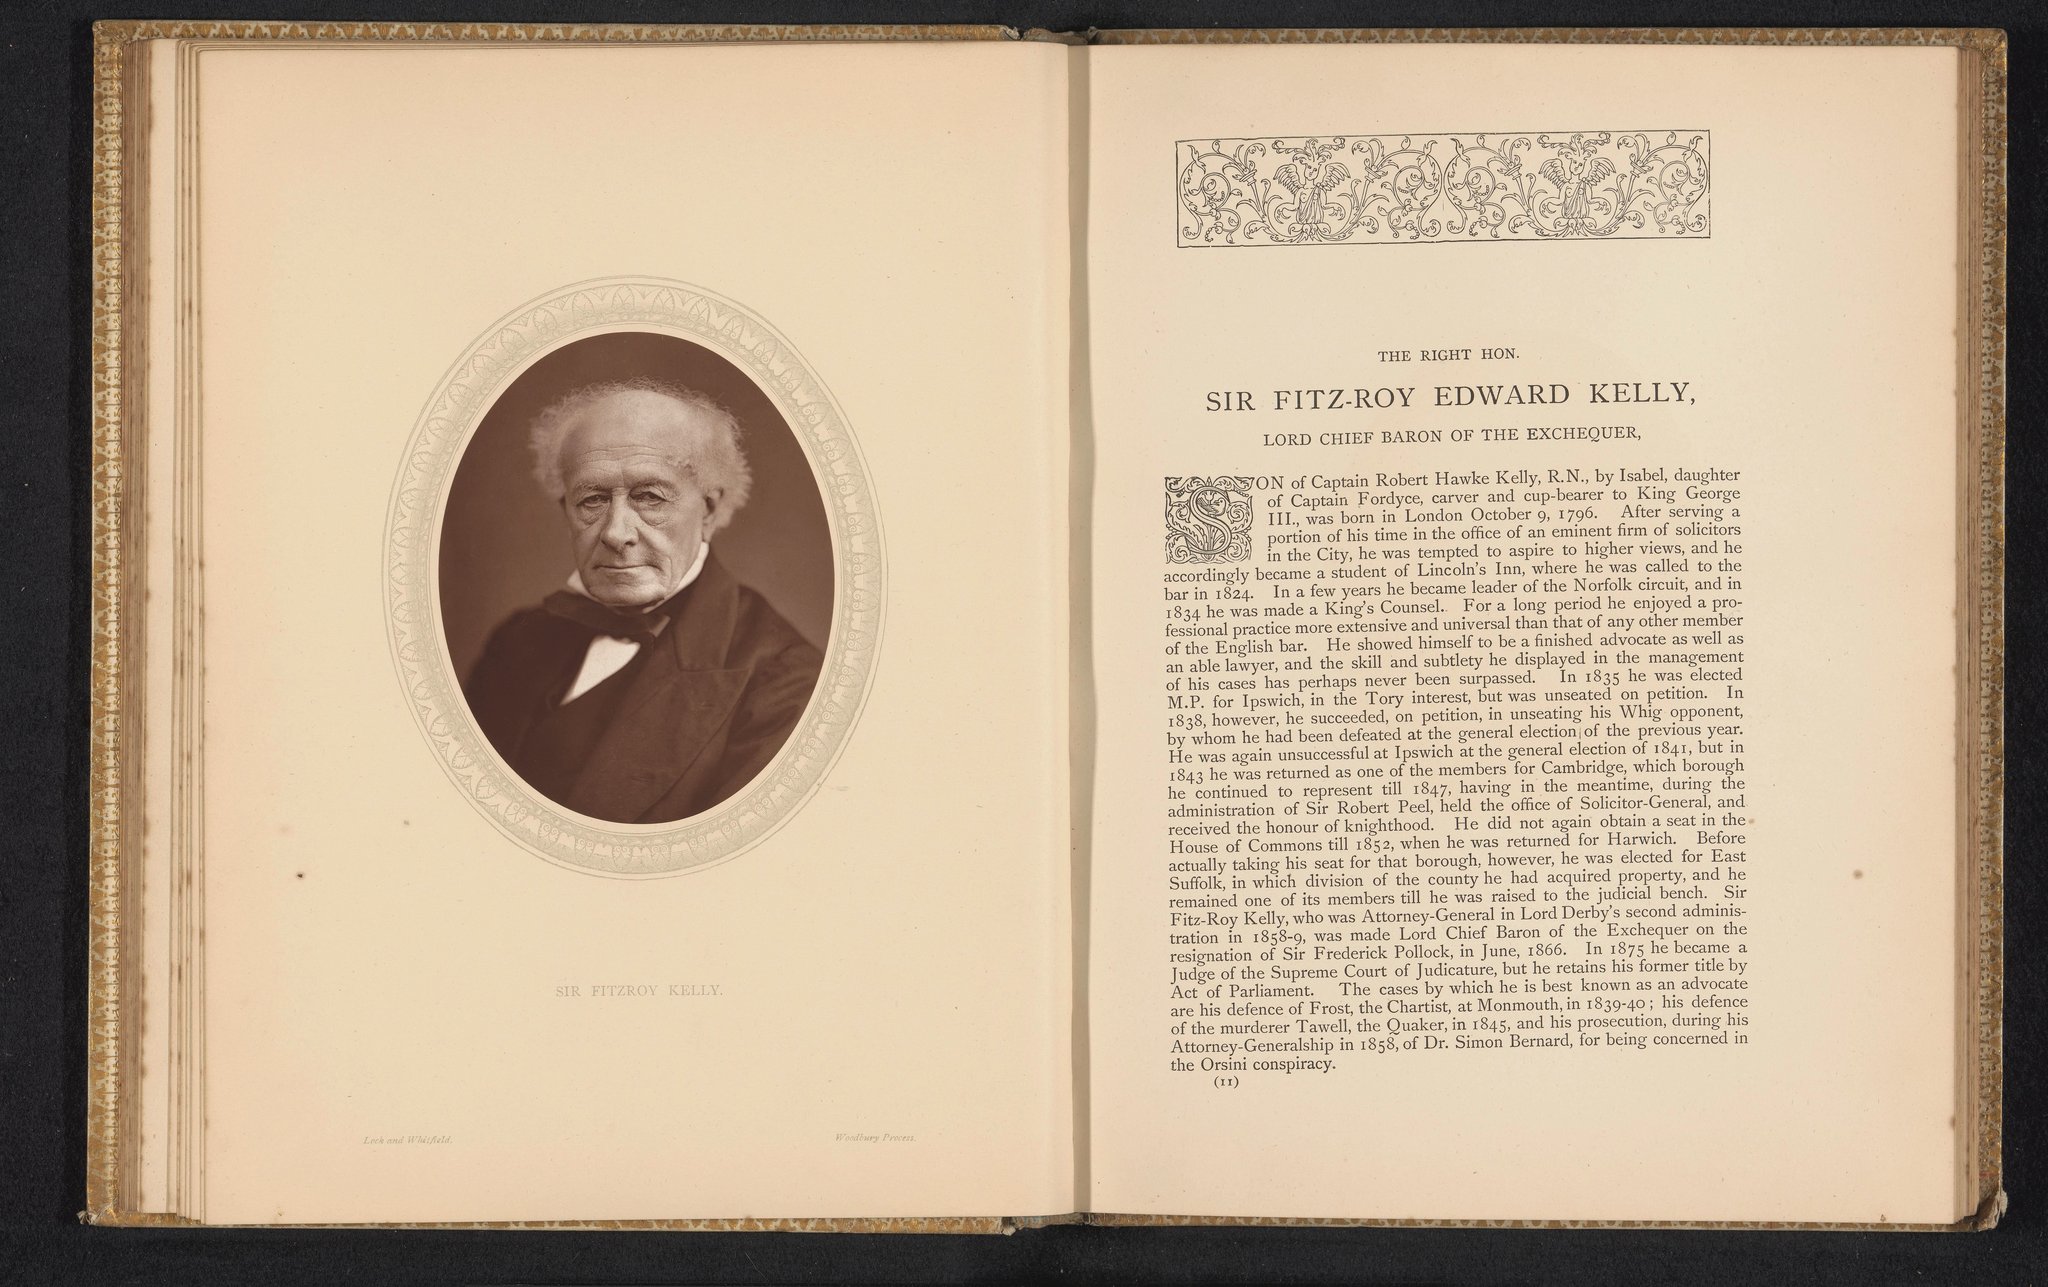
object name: page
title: Sir Fitzroy Kelly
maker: Anonymous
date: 1875-1880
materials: paper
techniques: woodburytype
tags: historical persons (portraits and scenes from the life) (+ (full) bust portrait), magistracy, judges